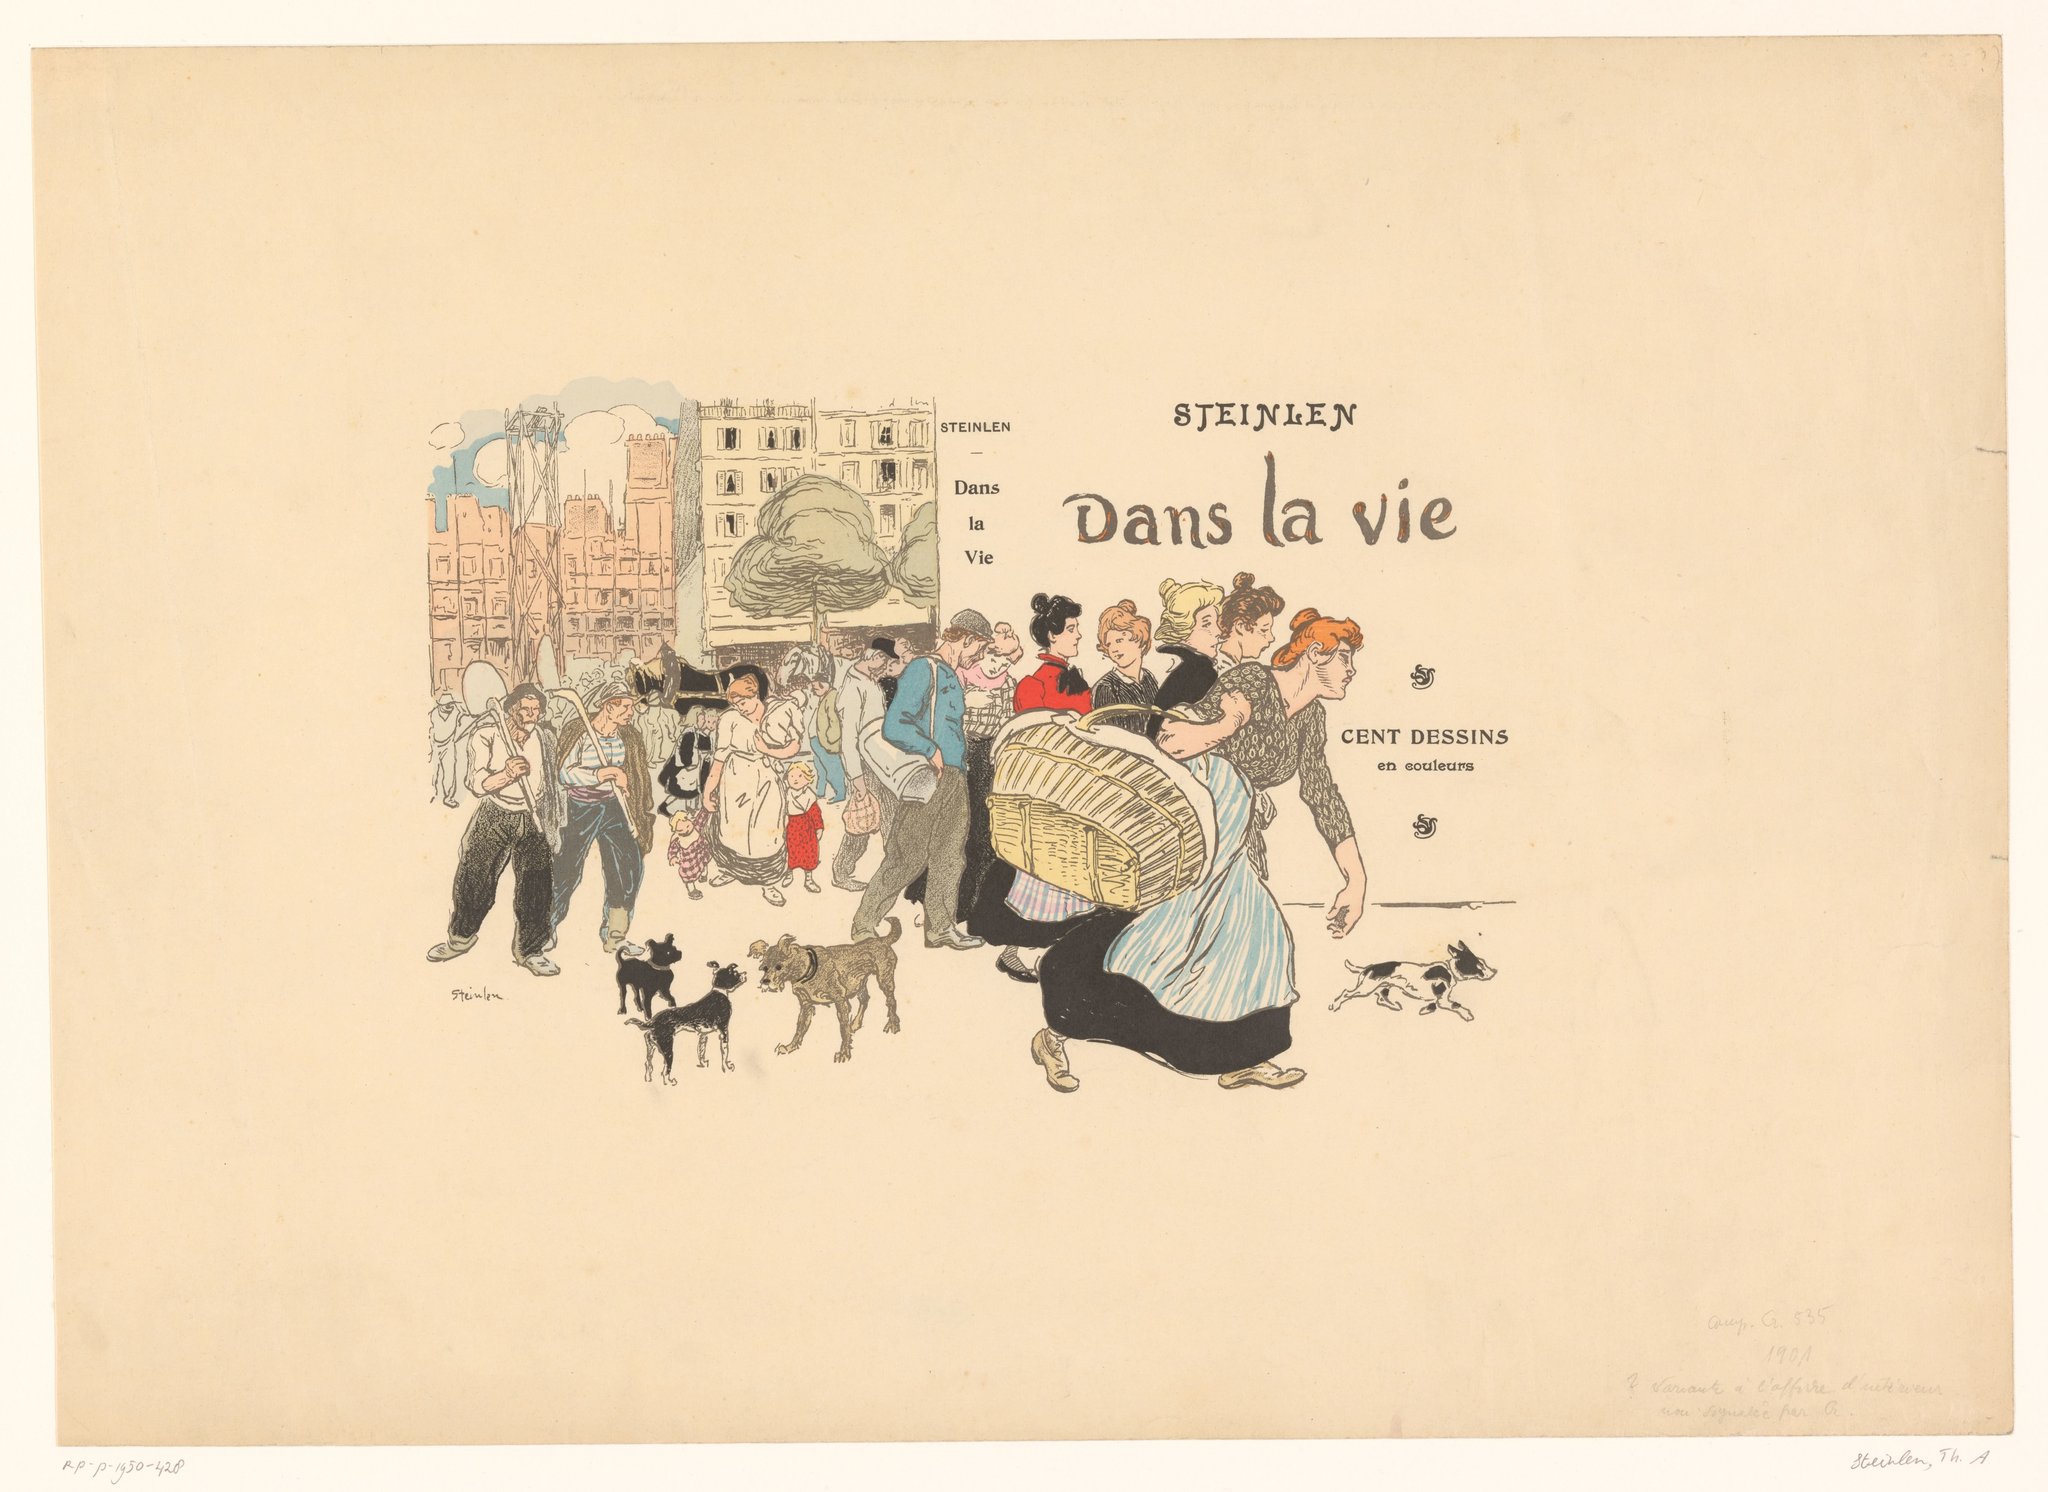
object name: print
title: Omslag voor prenten over het dagelijks leven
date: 1901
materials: paper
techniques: lithograph, hand coloring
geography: paris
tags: urban life, rural life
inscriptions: collector's mark: Lugt 2228